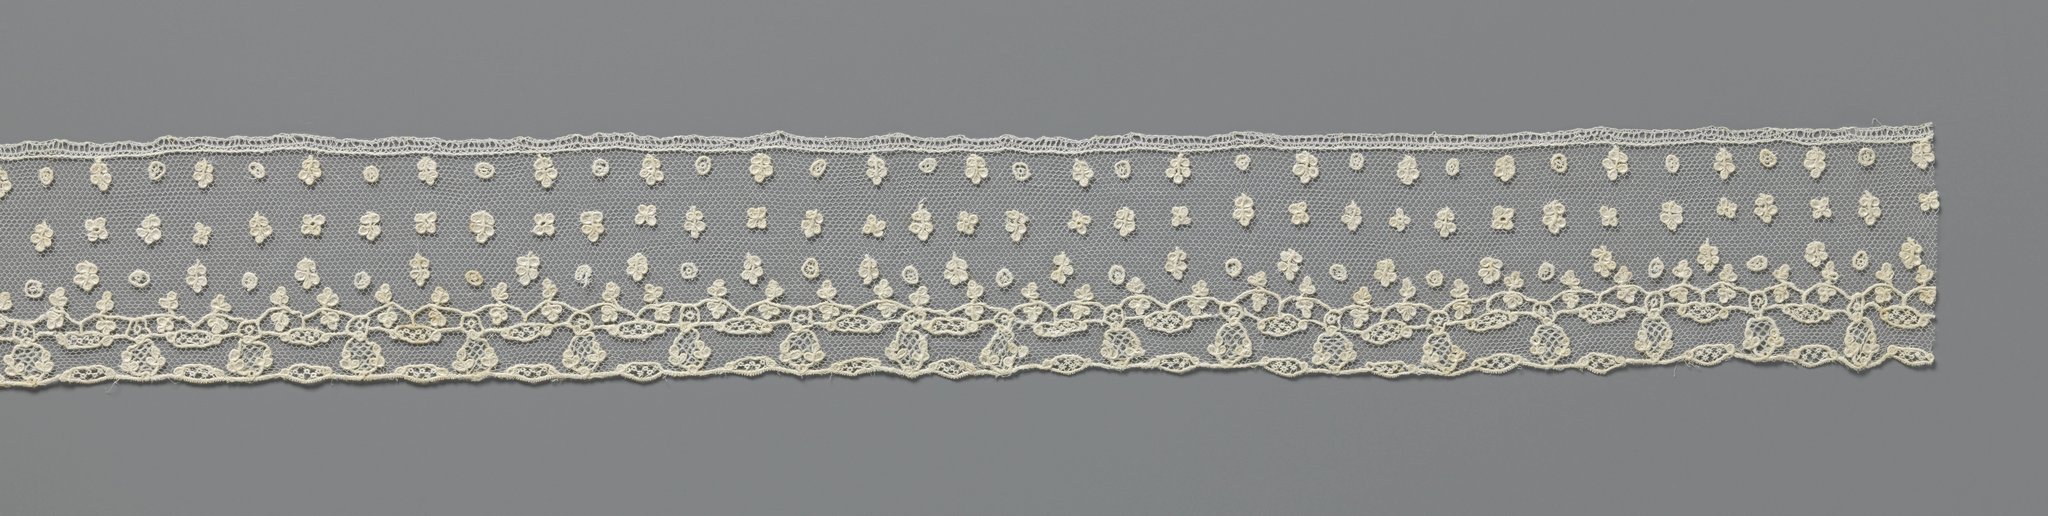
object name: strip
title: Strook naaldkant met drie rijen takjes, bloemen en raderpicots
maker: Anonymous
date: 1790-1795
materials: linen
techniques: lace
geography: alençon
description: Strook naturelkleurige naaldkant: Alençon-kant. Strooimotief met drie rijen van steeds een takje afgewisseld met een vierbladige bloem of met een raderpicot in een cirkelvormig cordon. Het strooimotief staat op een fijne zeshoekige maasgrond. Het patroon aan de onderzijde van de strook bestaat uit boogjes met aan weerszijden drievoudige blaadjes. Daaronder liggende en staande ovalen, gevuld met siergronden. De onderzijde is afgewerkt met een vrijwel rechte rand met ragfijne picots. De bovenzijde is afgezet met een rand kloskant.